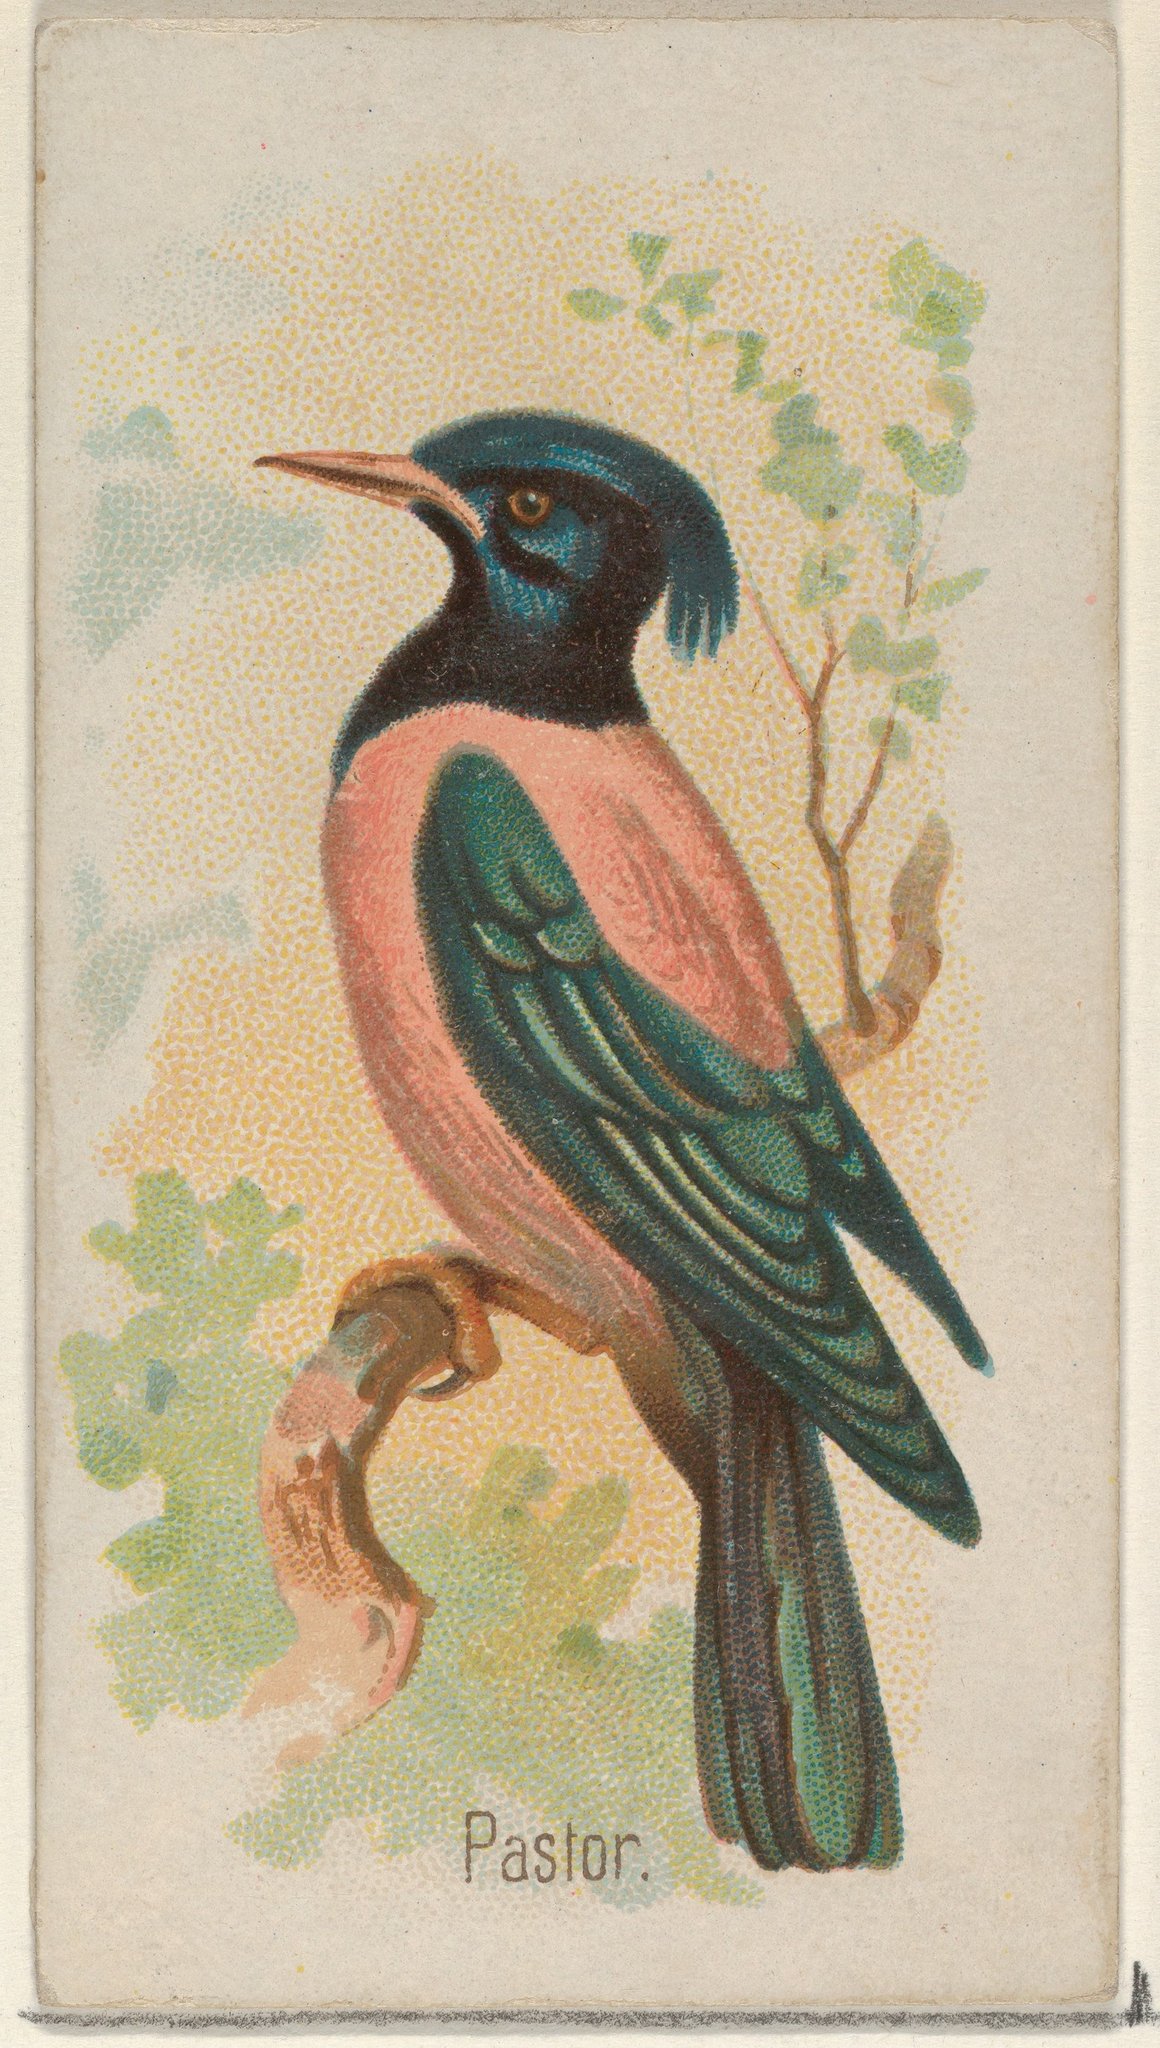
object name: print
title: Pastor, from the Song Birds of the World series (N23) for Allen & Ginter Cigarettes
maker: allen & ginter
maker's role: publisher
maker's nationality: american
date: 1890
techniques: color lithograph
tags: birds